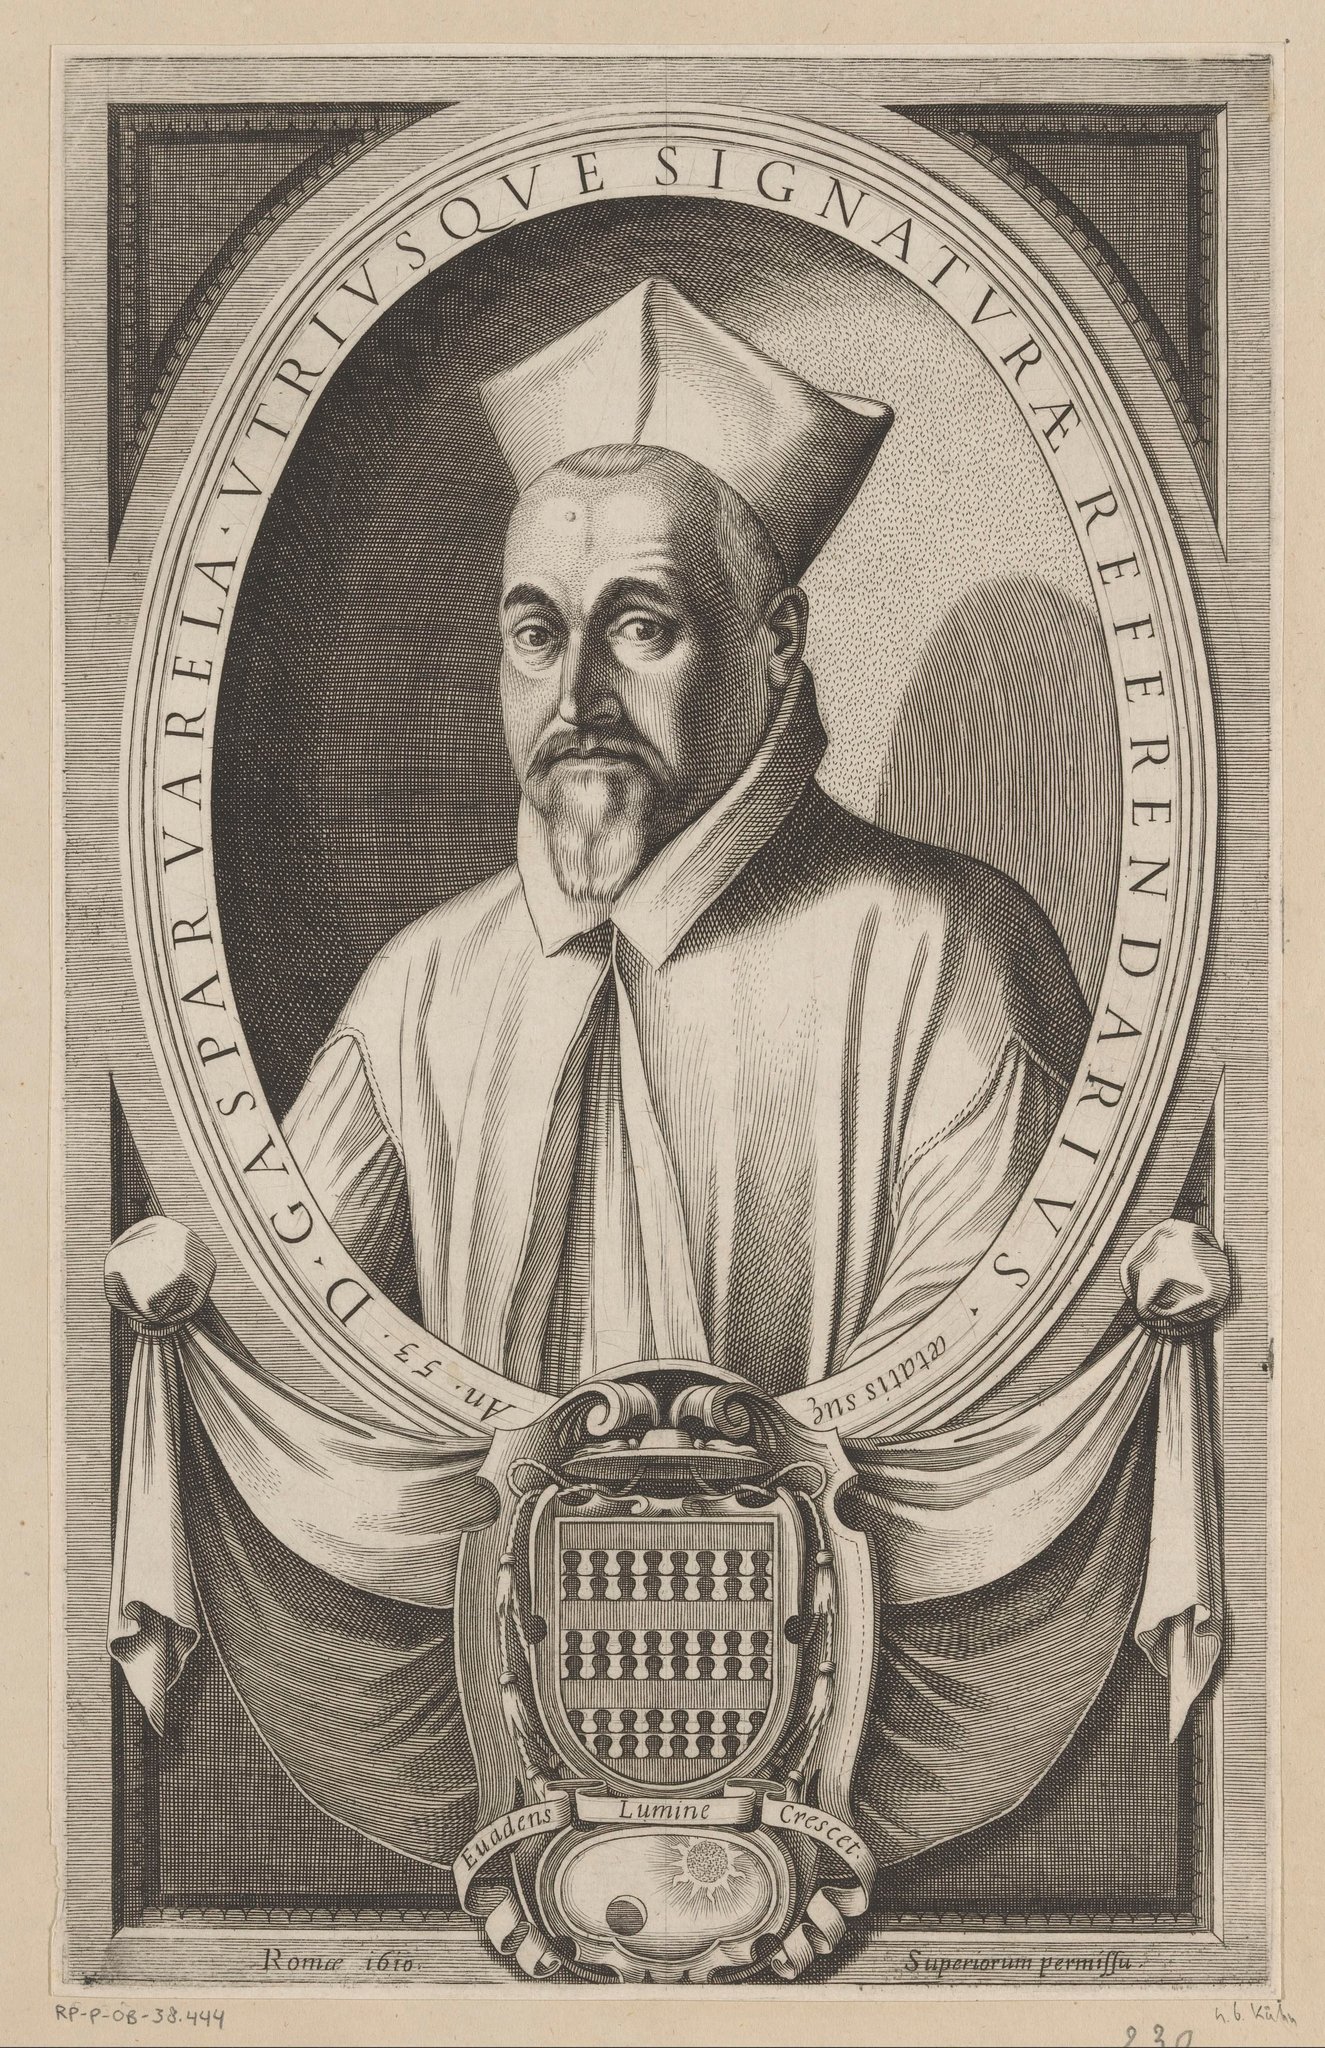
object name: print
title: Portret van Gaspar Varela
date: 1610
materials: paper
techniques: engraving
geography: italy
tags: historical persons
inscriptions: collector's mark: Lugt 240